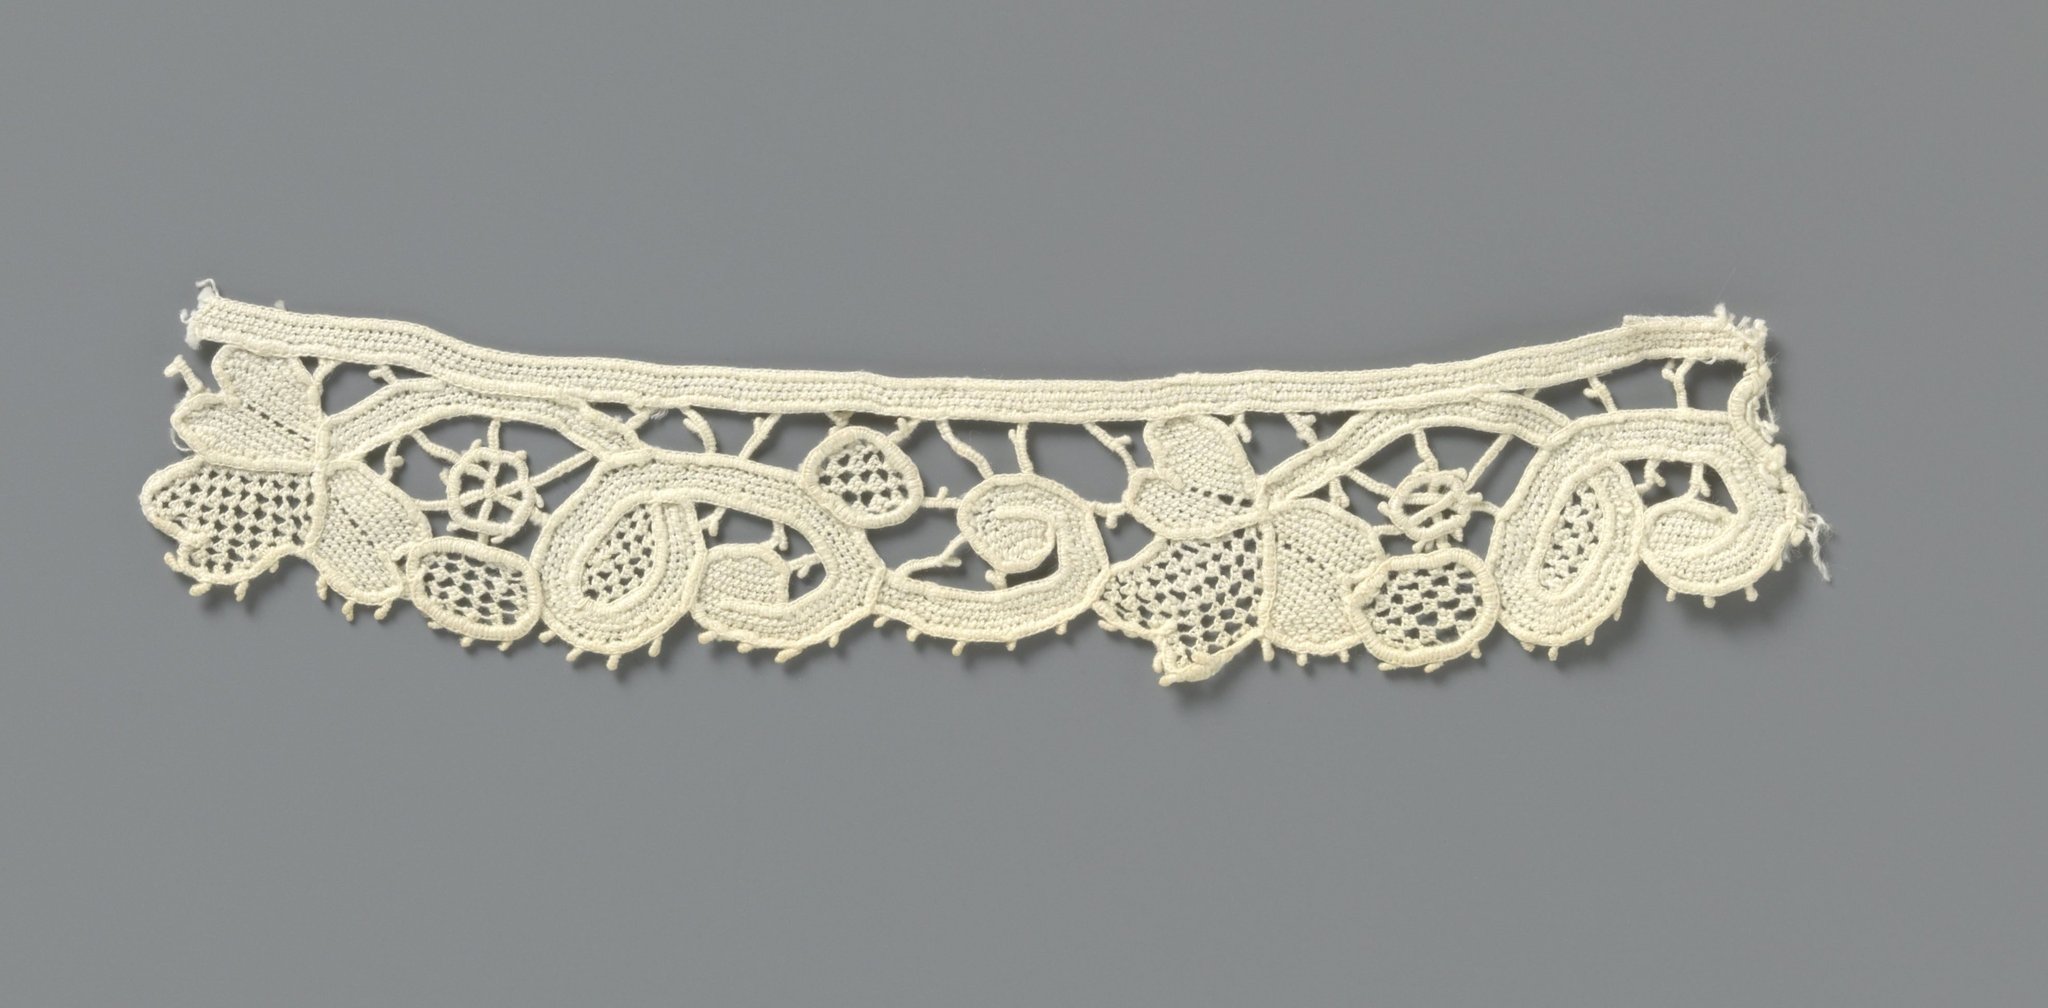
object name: strip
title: Strook naaldkant met bloem of blad aan krullende steel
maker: Anonymous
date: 1850-1899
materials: cotton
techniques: needlepoint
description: Strook naturelkleurige Venetiaanse naaldkant. Repetitief motief van een bloem of een driedelig blad aan een krullende steel op een onregelmatige spijlengrond met picots. Volwerk van festonsteken met uitsparingen langs een enkele bladnerf en enkele vlakken zijn ingevuld met een siergrond. Gefestonneerde contourdraden. De bovenzijde is afgewerkt met een rechte rand. De randen van de motieven zijn aan de onderzijde afgewerkt met picots.